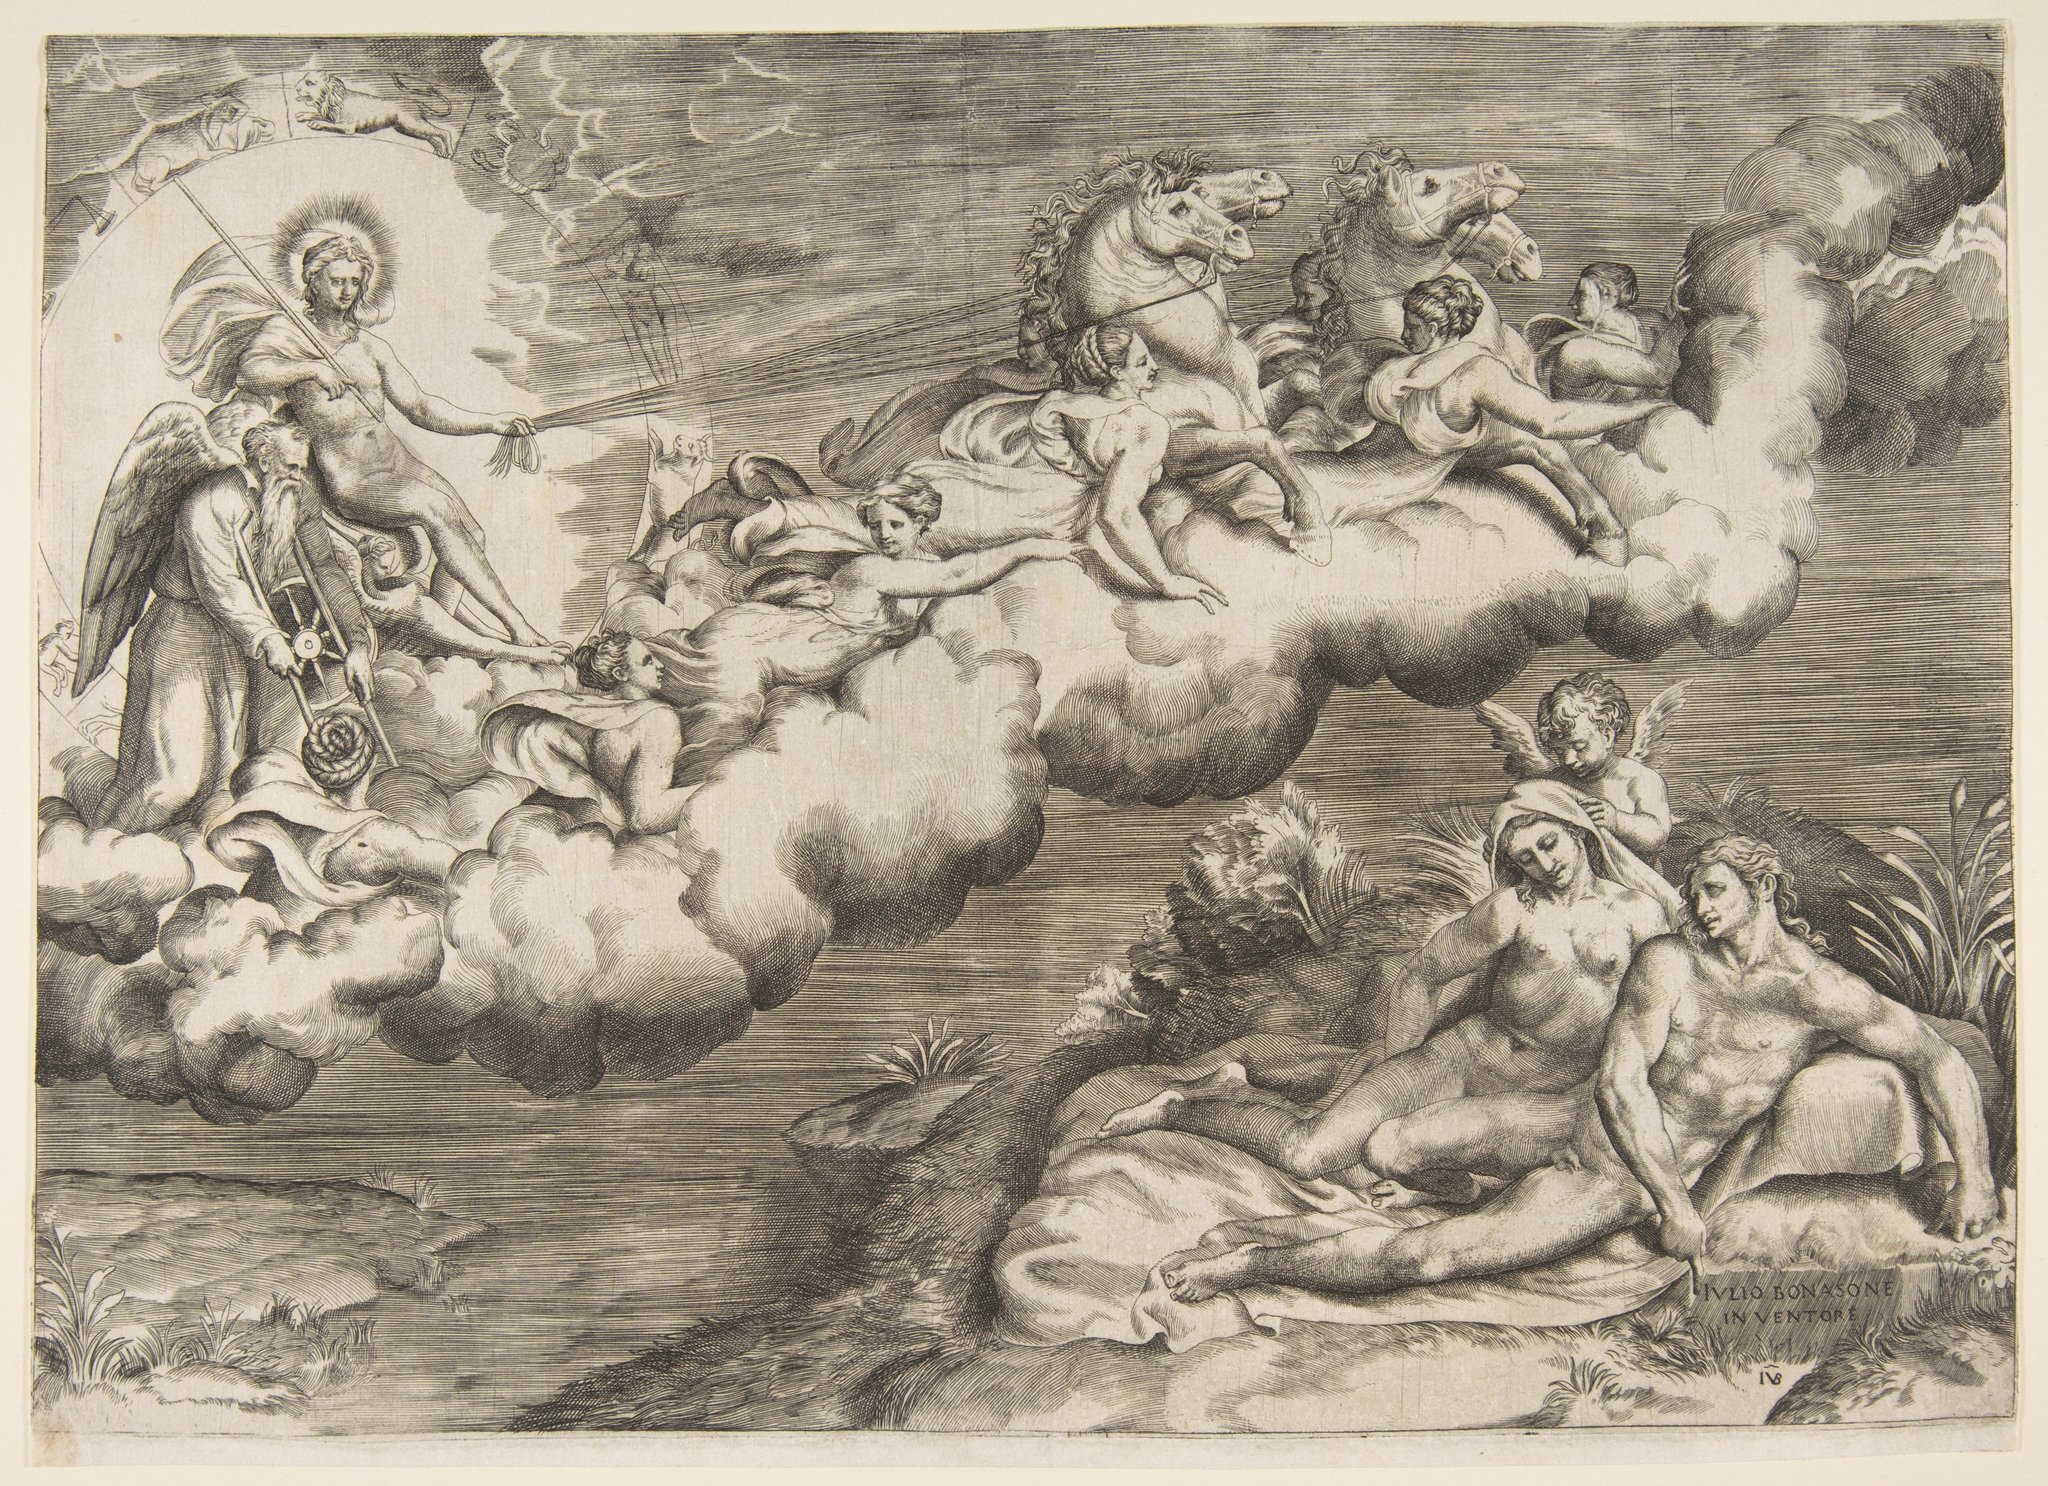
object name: print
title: An allegory of the rising sun, a naked man wearing a shroud and accompanied Father Time is being drawn by horses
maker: giulio bonasone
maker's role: artist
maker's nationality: italian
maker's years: 1510-1576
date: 1531-1576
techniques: engraving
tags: male nudes,female nudes,horses